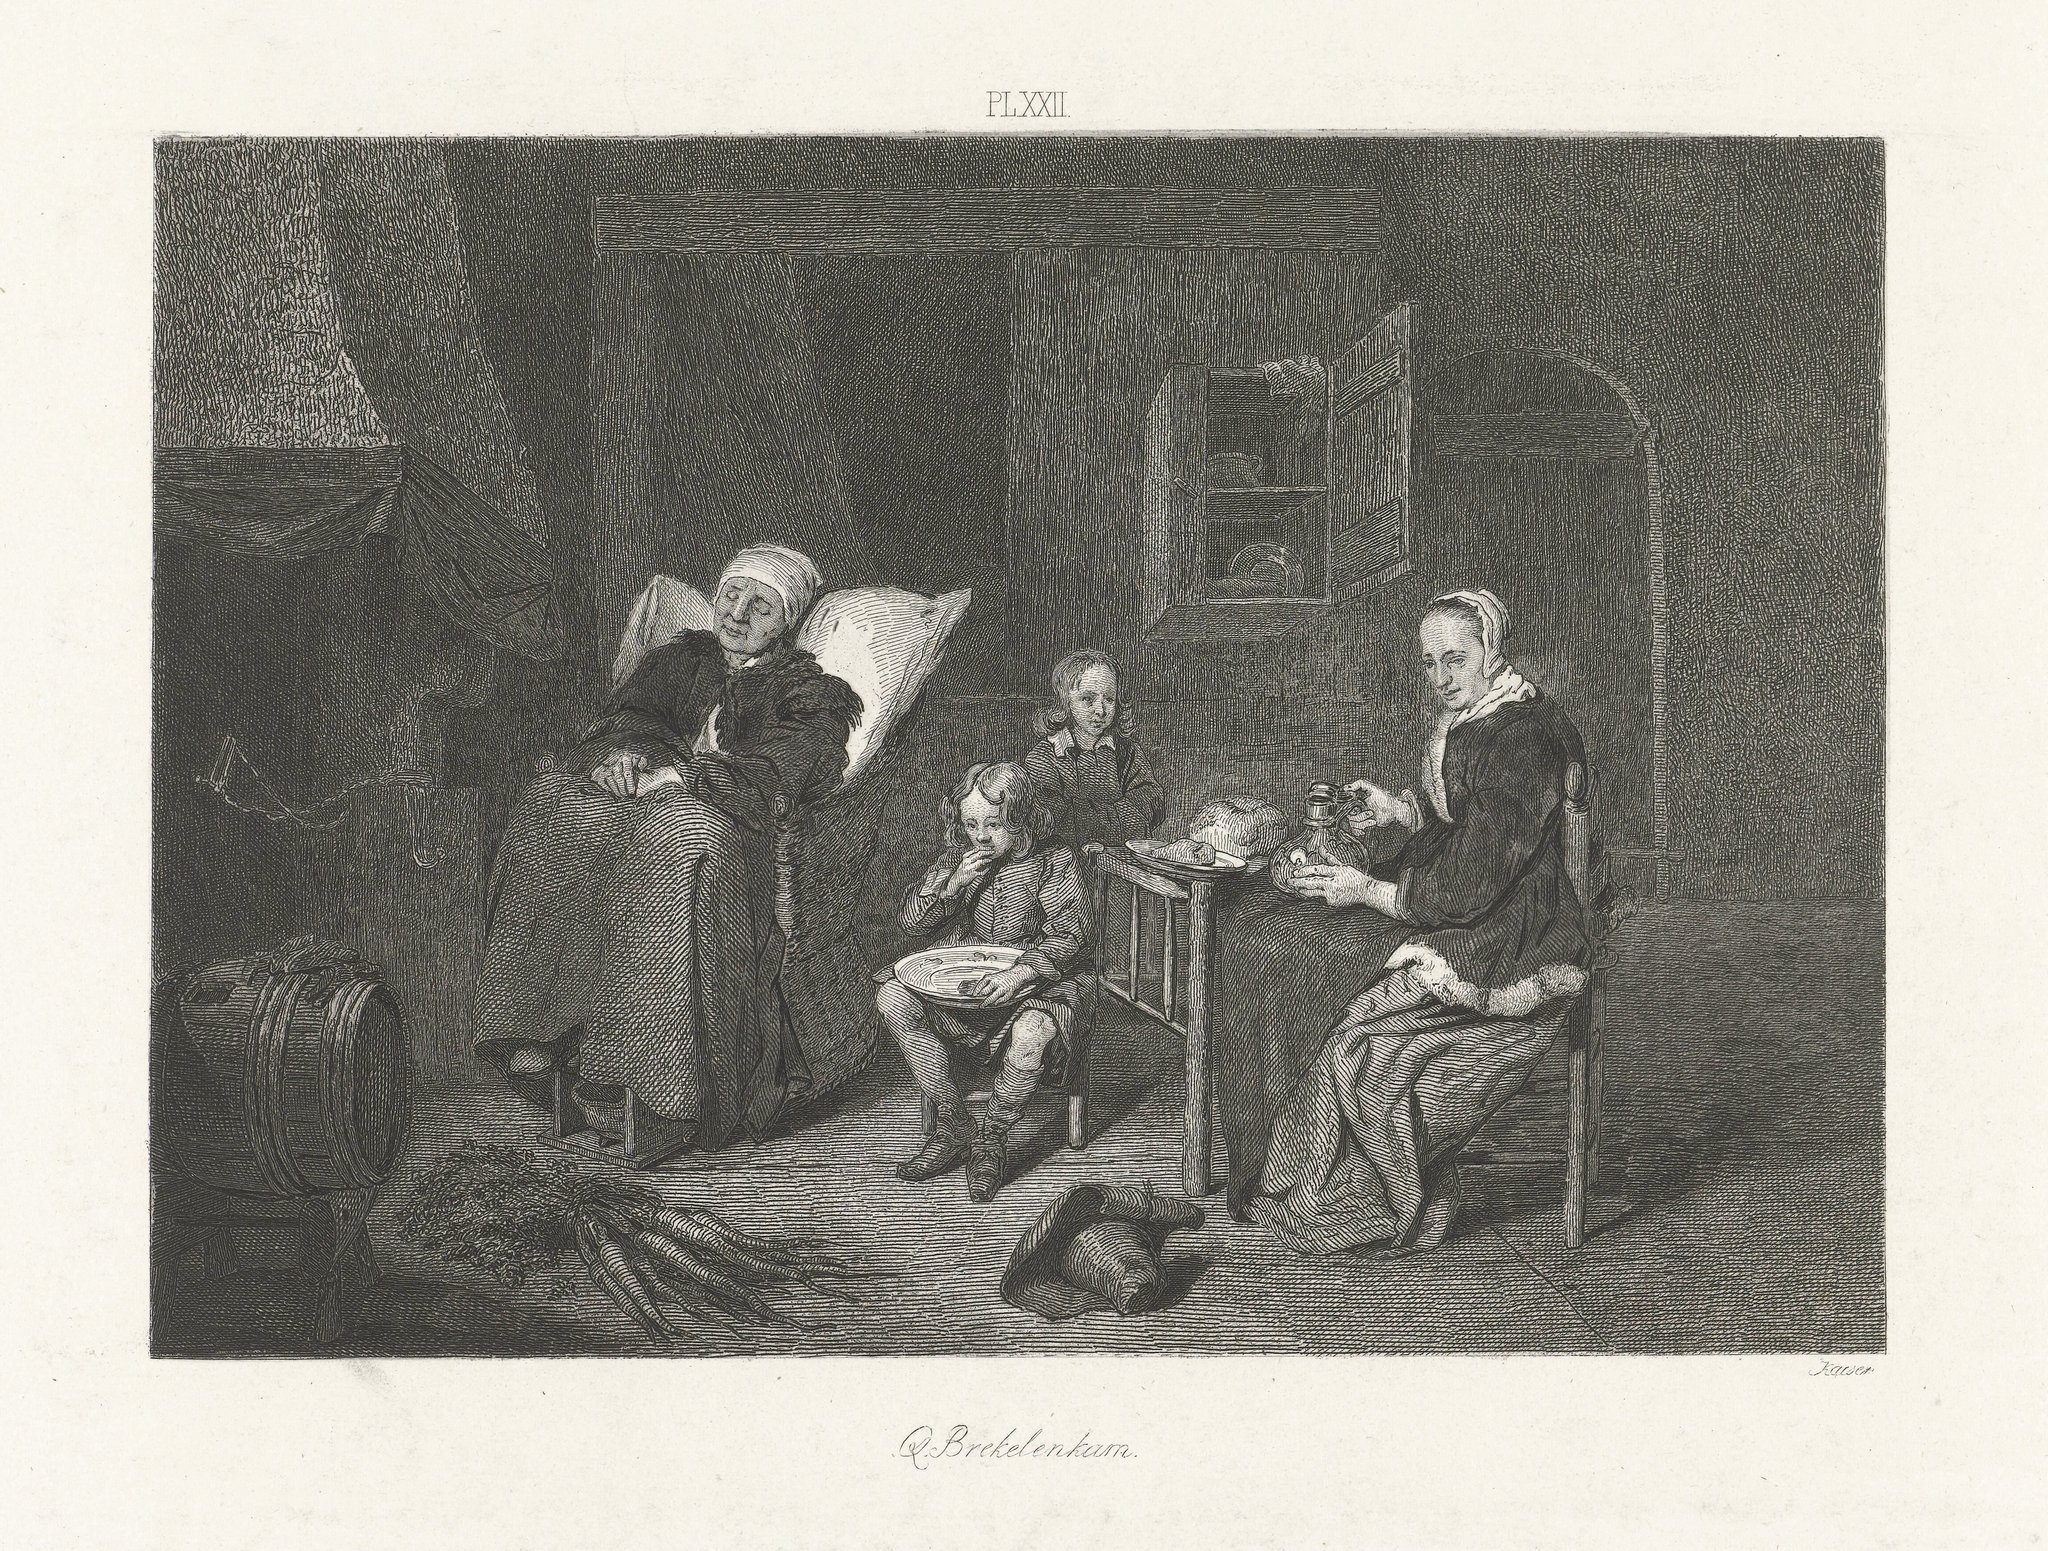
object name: print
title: Interieur met slapende vrouw voor een schouw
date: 1823-1900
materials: paper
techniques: etching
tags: sleeping; unconsciousness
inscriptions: collector's mark: Lugt 2228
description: Een interieur met een slapende vrouw voor een schouw waar een jongen naast zit te eten. Achter de jongen een andere jongen. Rechts zit een vrouw met een kan op haar schoot bij een tafel. Op de voorgrond liggen een hoed en een bos wortelen. De prent maakt deel uit van een serie van 25 prenten naar Hollandse meesters. Boven de afbeelding: PL XXII.